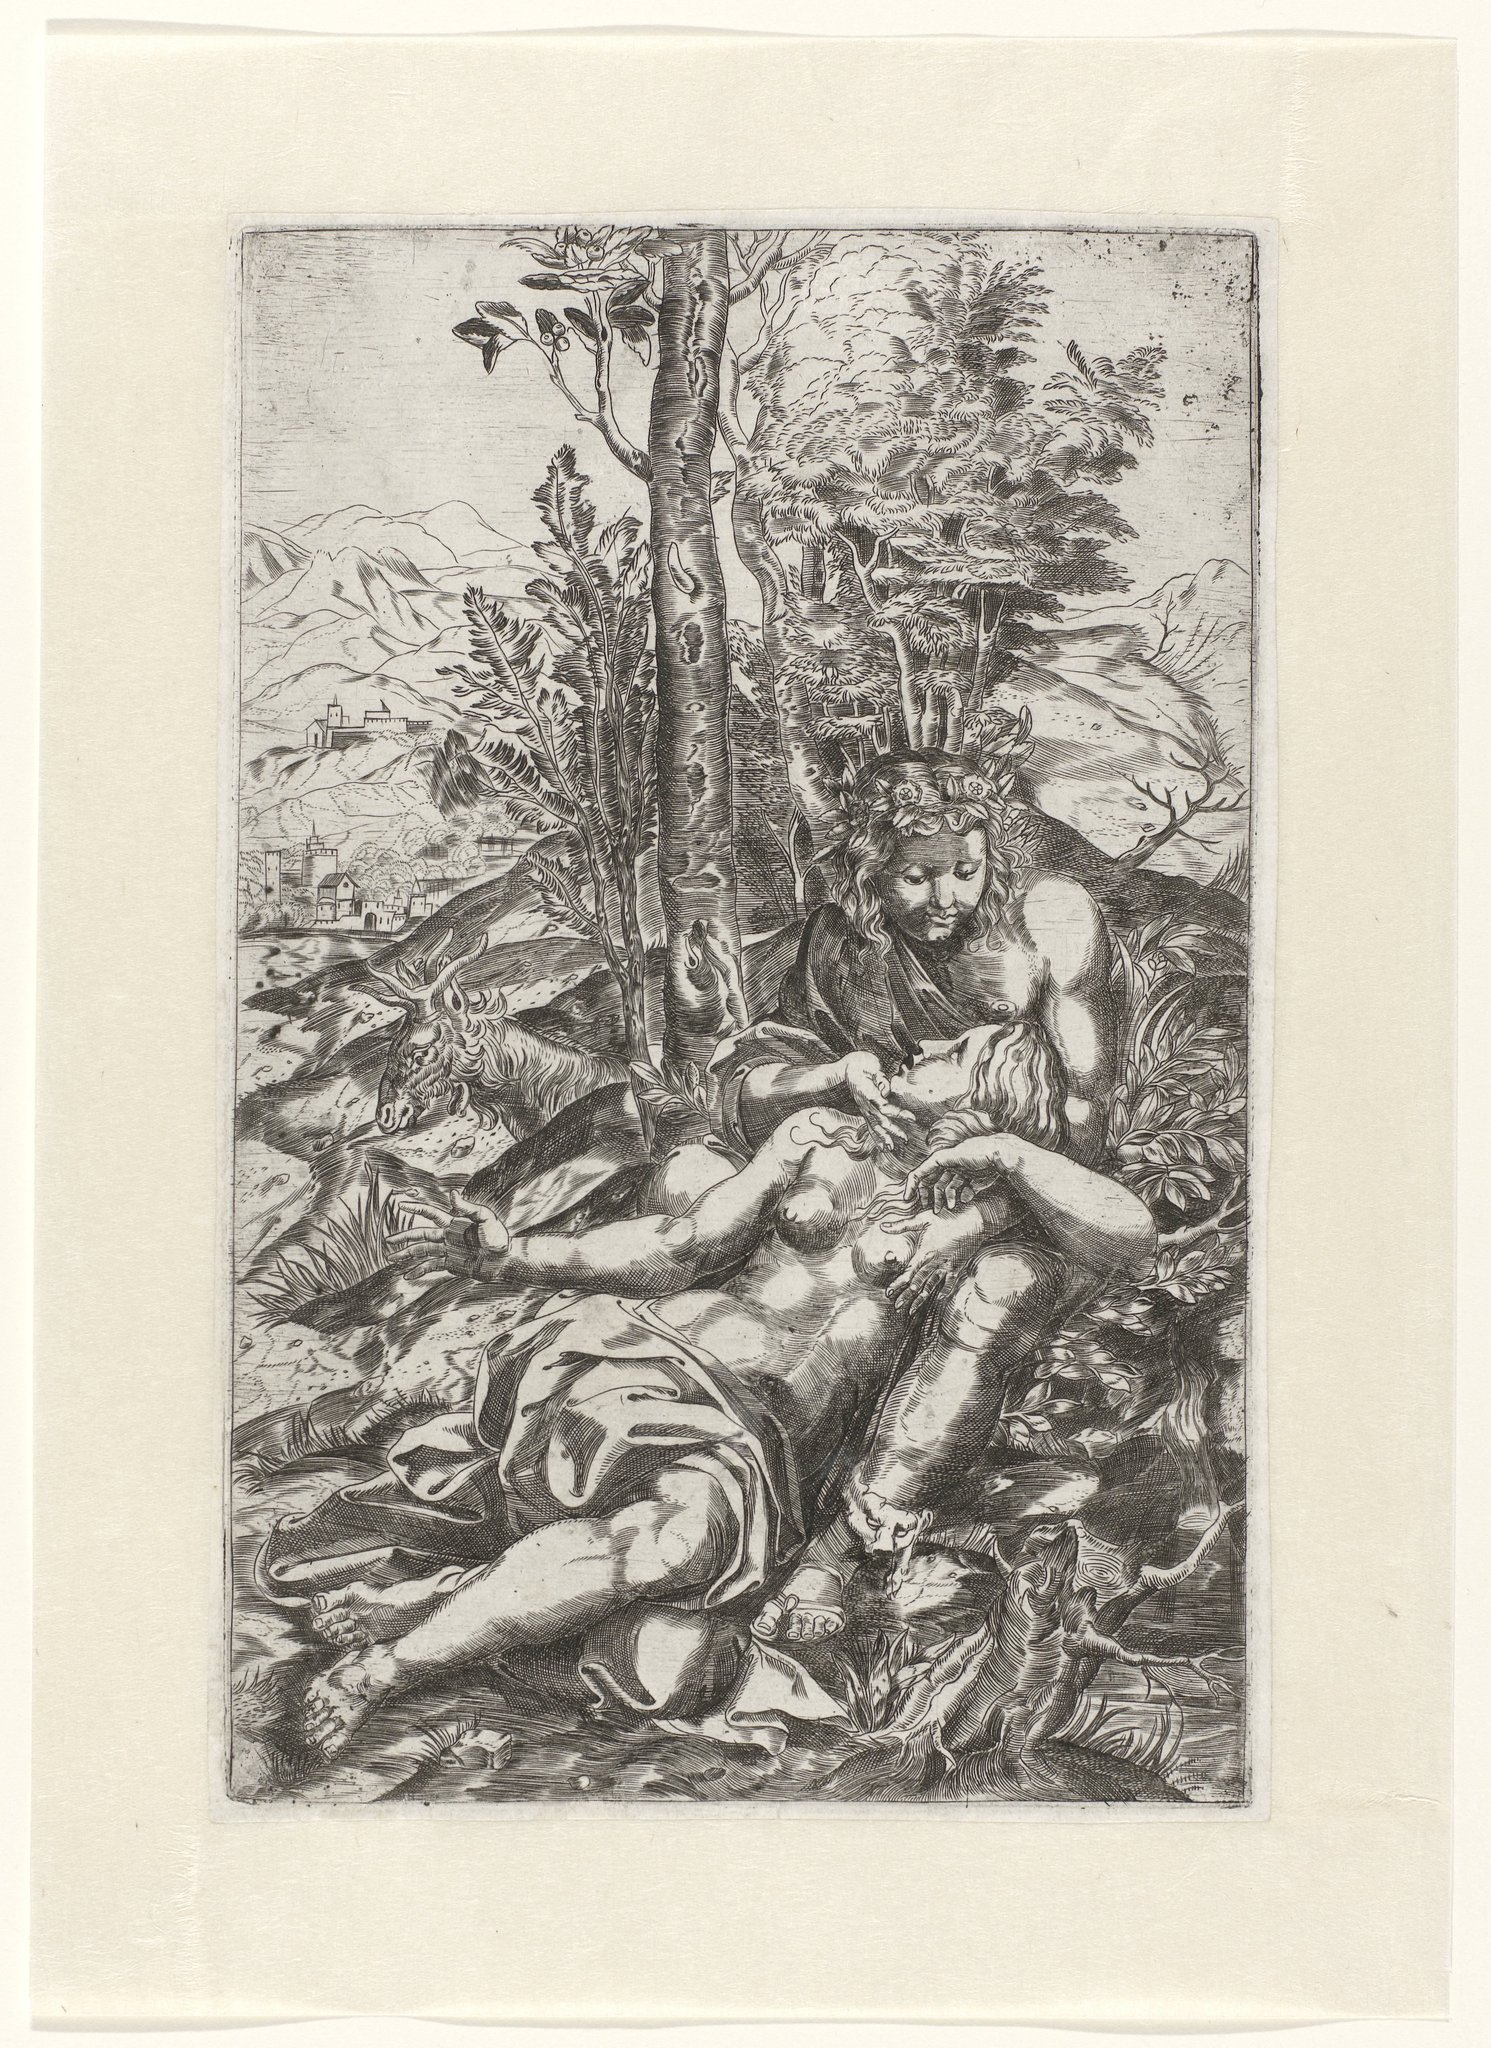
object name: print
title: Medoro en Angelica in een landschap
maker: Anonymous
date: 1520-1540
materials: paper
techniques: engraving, intaglio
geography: italy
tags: medoro, angelica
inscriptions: collector's mark: Lugt 2228, collector's mark: Lugt 2760, collector's mark: Lugt 617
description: Medoro zit op de grond en het hoofd van Angelica ligt in zijn schoot. Een bosrijk landschap met hert en een stad op de achtergrond. Scène afkomstig uit Ludovico Ariosto's epos 'Orlando Furioso' (1532).